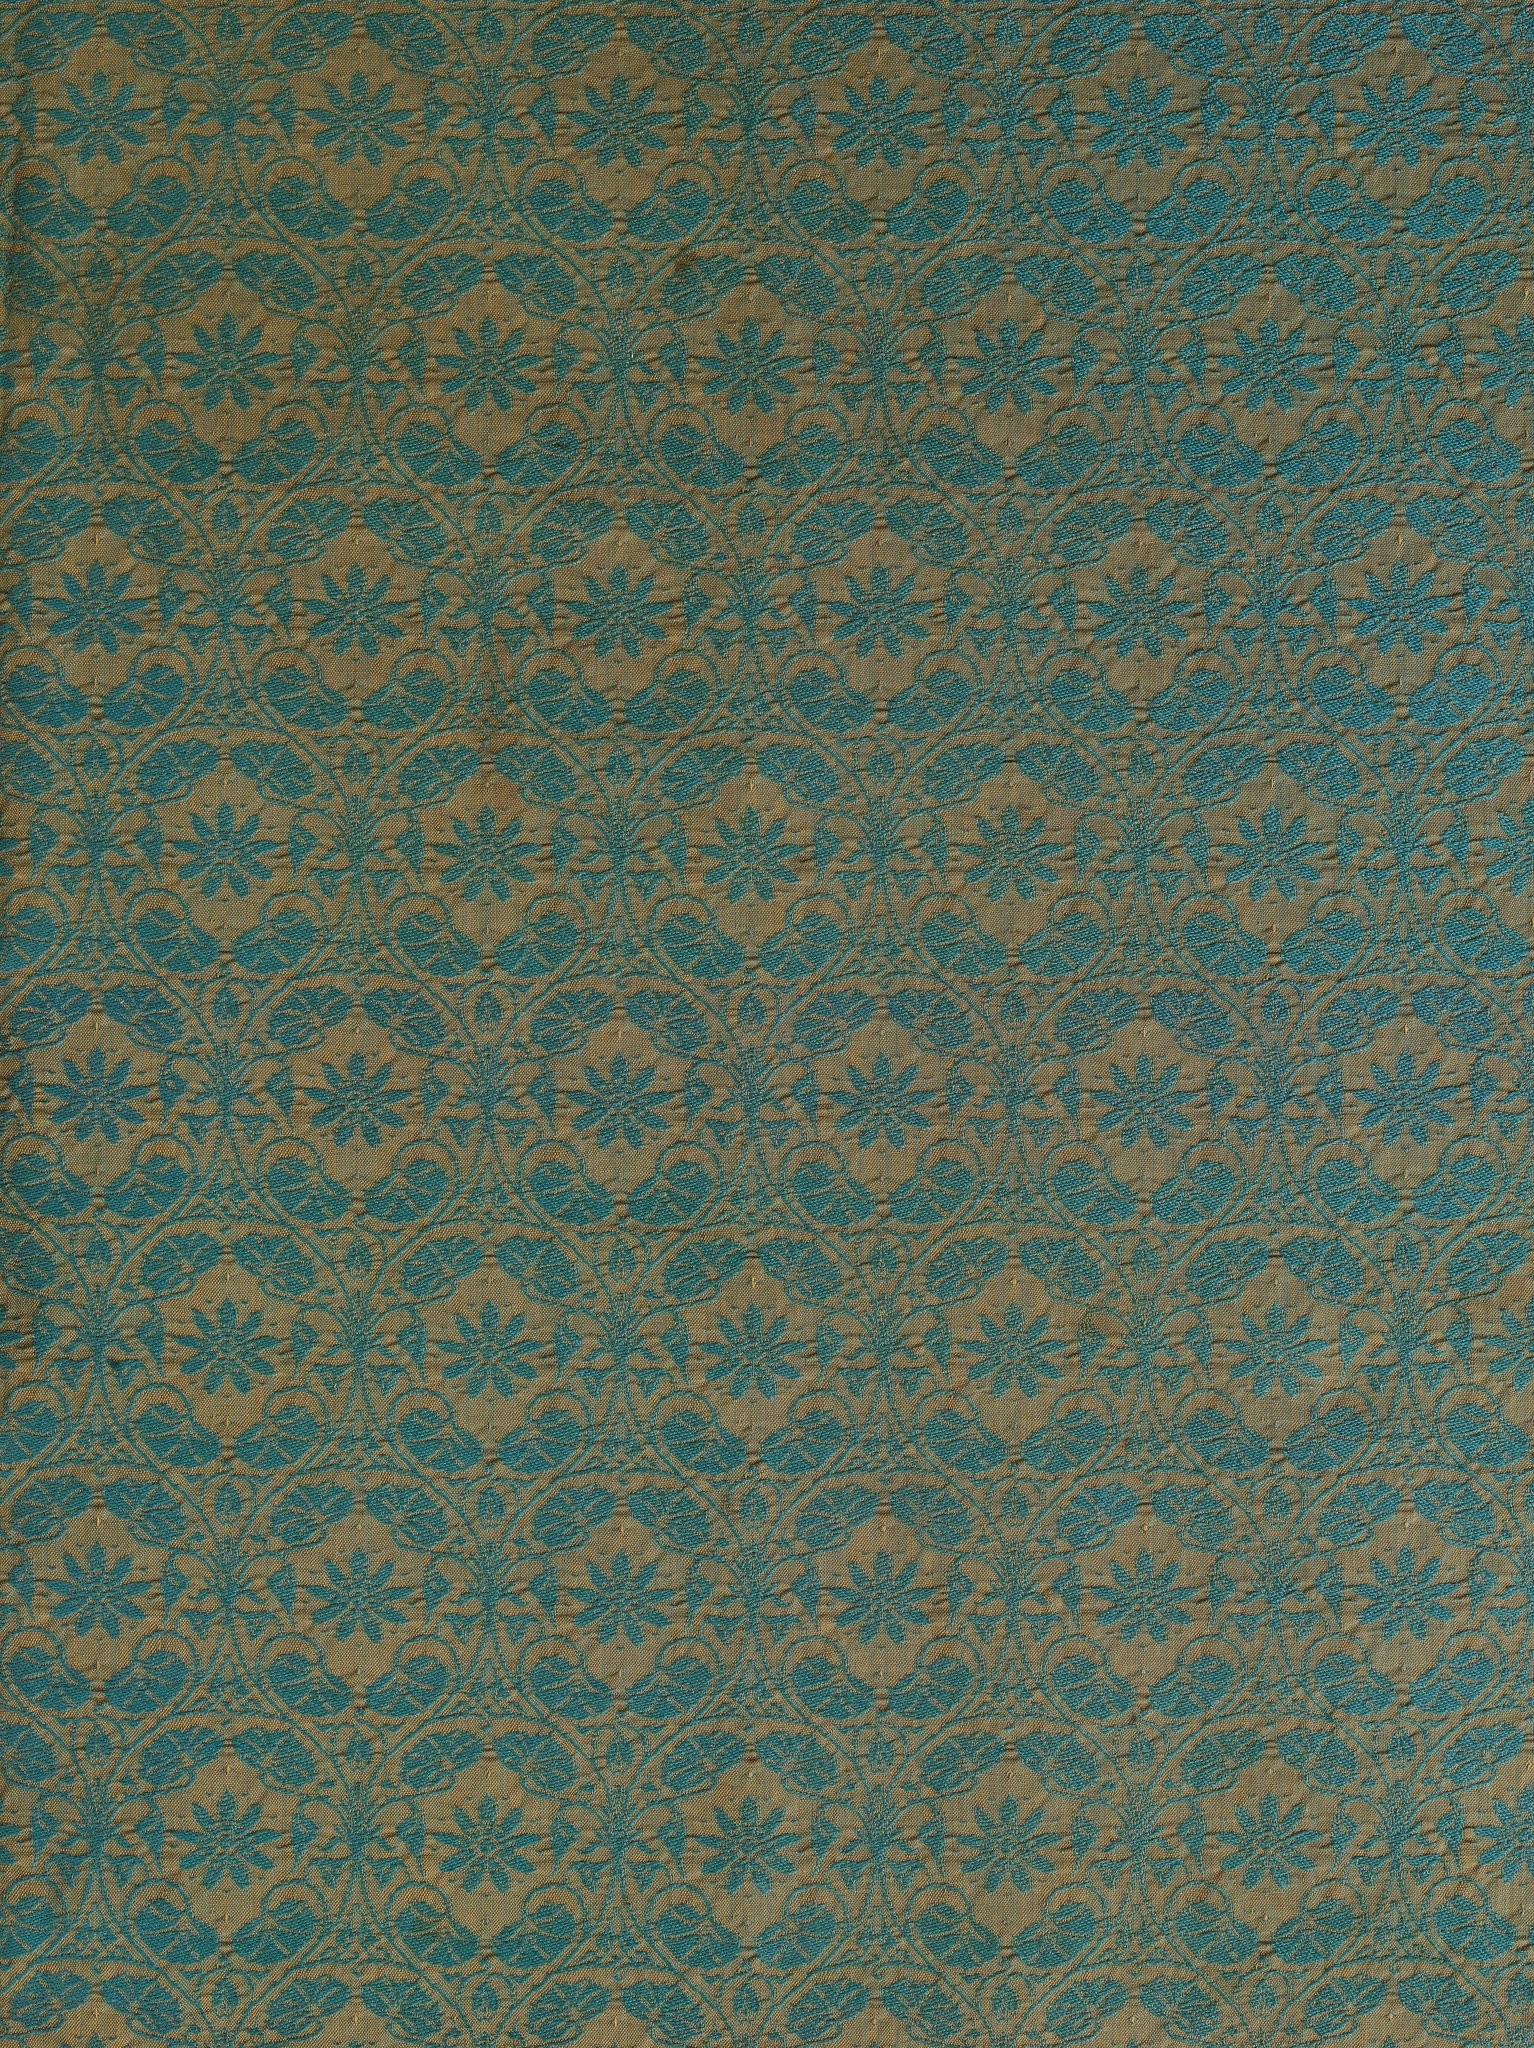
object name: curtain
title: Gordijn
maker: theo nieuwenhuis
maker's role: designer, draughtsman, print maker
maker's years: 1866-1951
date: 1880-1949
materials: cotton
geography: helmond